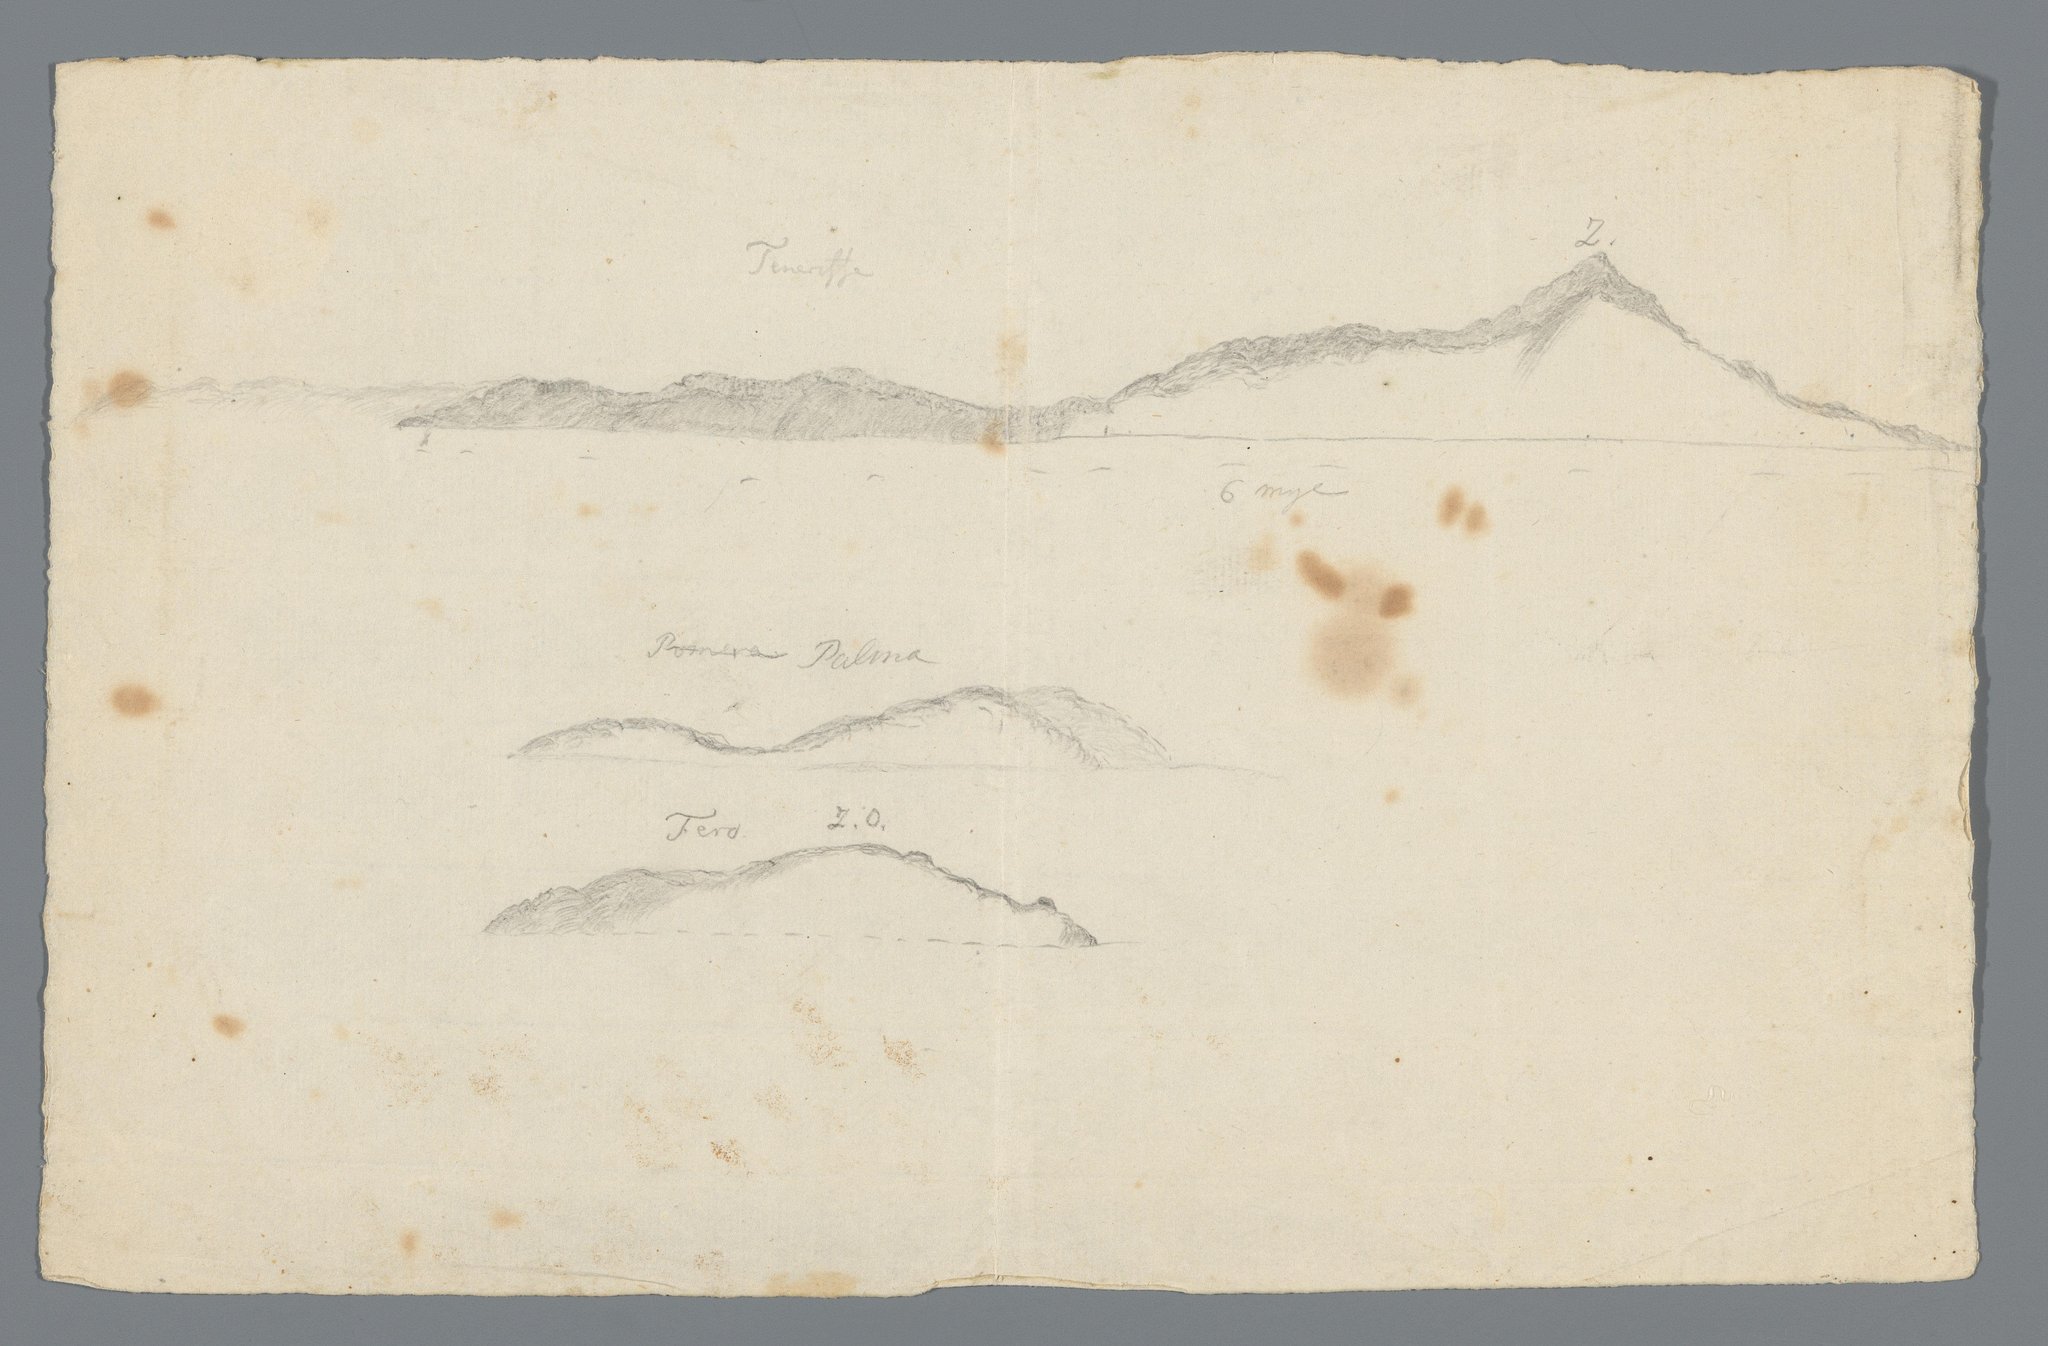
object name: drawing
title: Profielen van drie Canarische eilanden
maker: helena swellengrebel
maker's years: -1753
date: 1751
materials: paper, pencil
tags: island, sailing-ship, sailing-boat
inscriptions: label: ‘A4’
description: Profielen van drie Canarische eilanden, waarschijnlijk gemaakt op de reis van de Kaapkolonie naar Nederland door een van de dames Swellengrebel. Op de achterzijde enkele schrijfoefeningen met de pen.